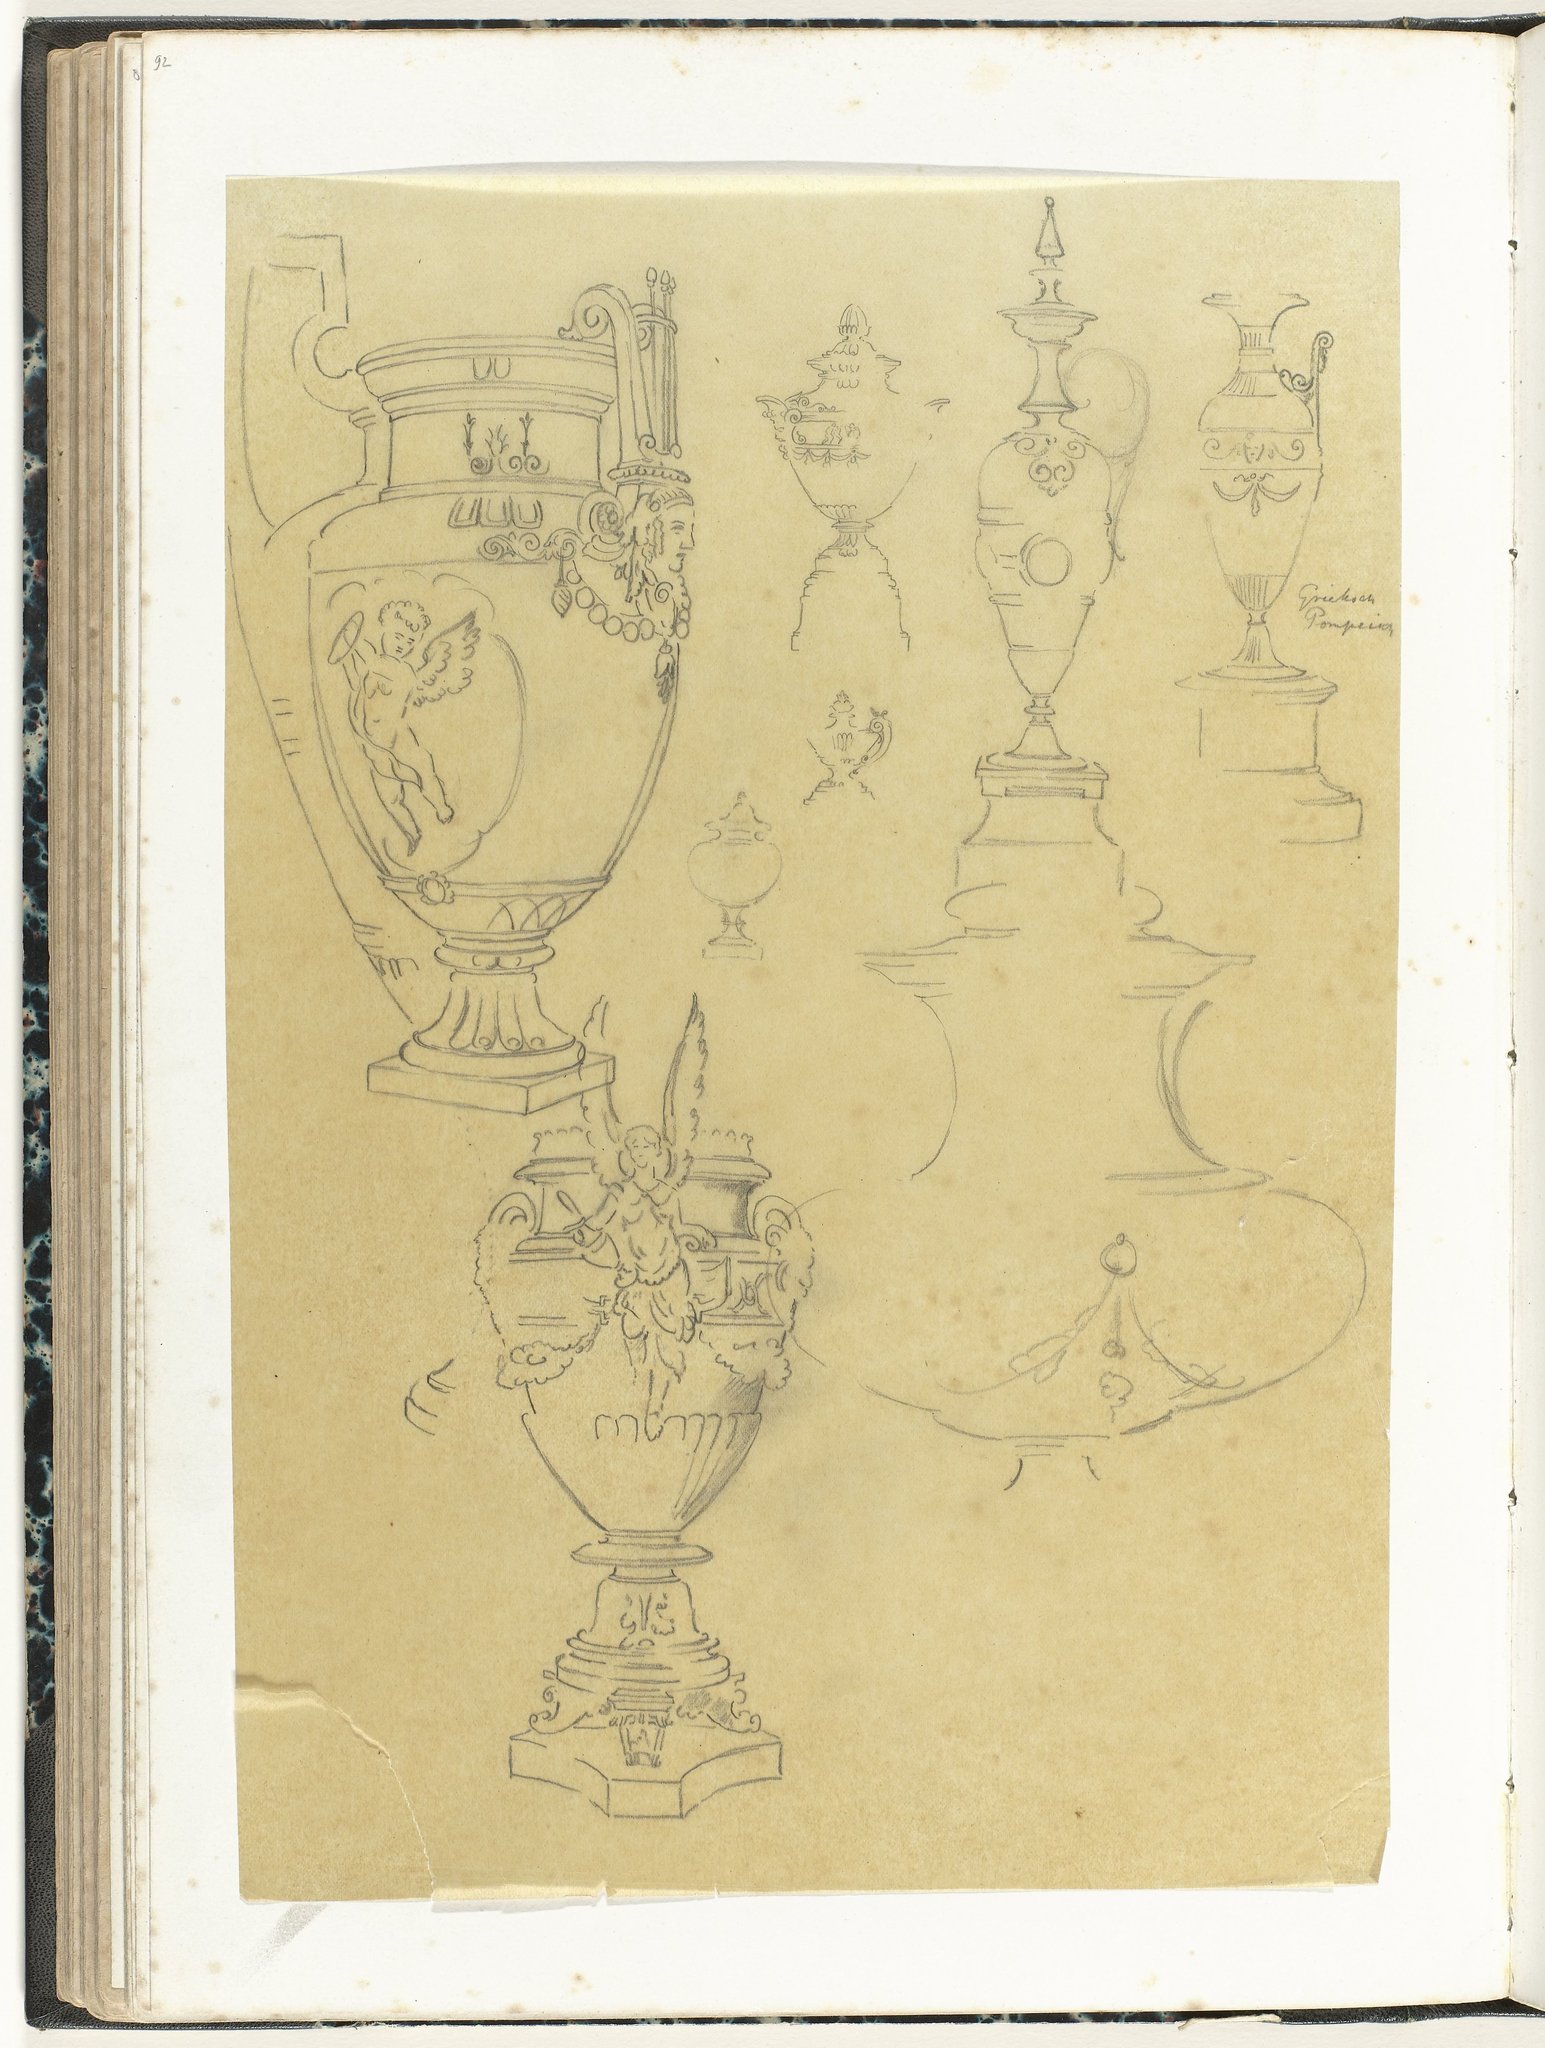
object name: drawing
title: Negen vazen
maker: Anonymous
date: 1866-1900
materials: pencil, paper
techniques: drawing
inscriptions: annotation: ‘Grieksch Pompeisch’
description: Links staan twee grote vazen die meer in detail zijn uitgewerkt dan de andere zeven, achter de bovenste is een schets te zien van nog een vaas.